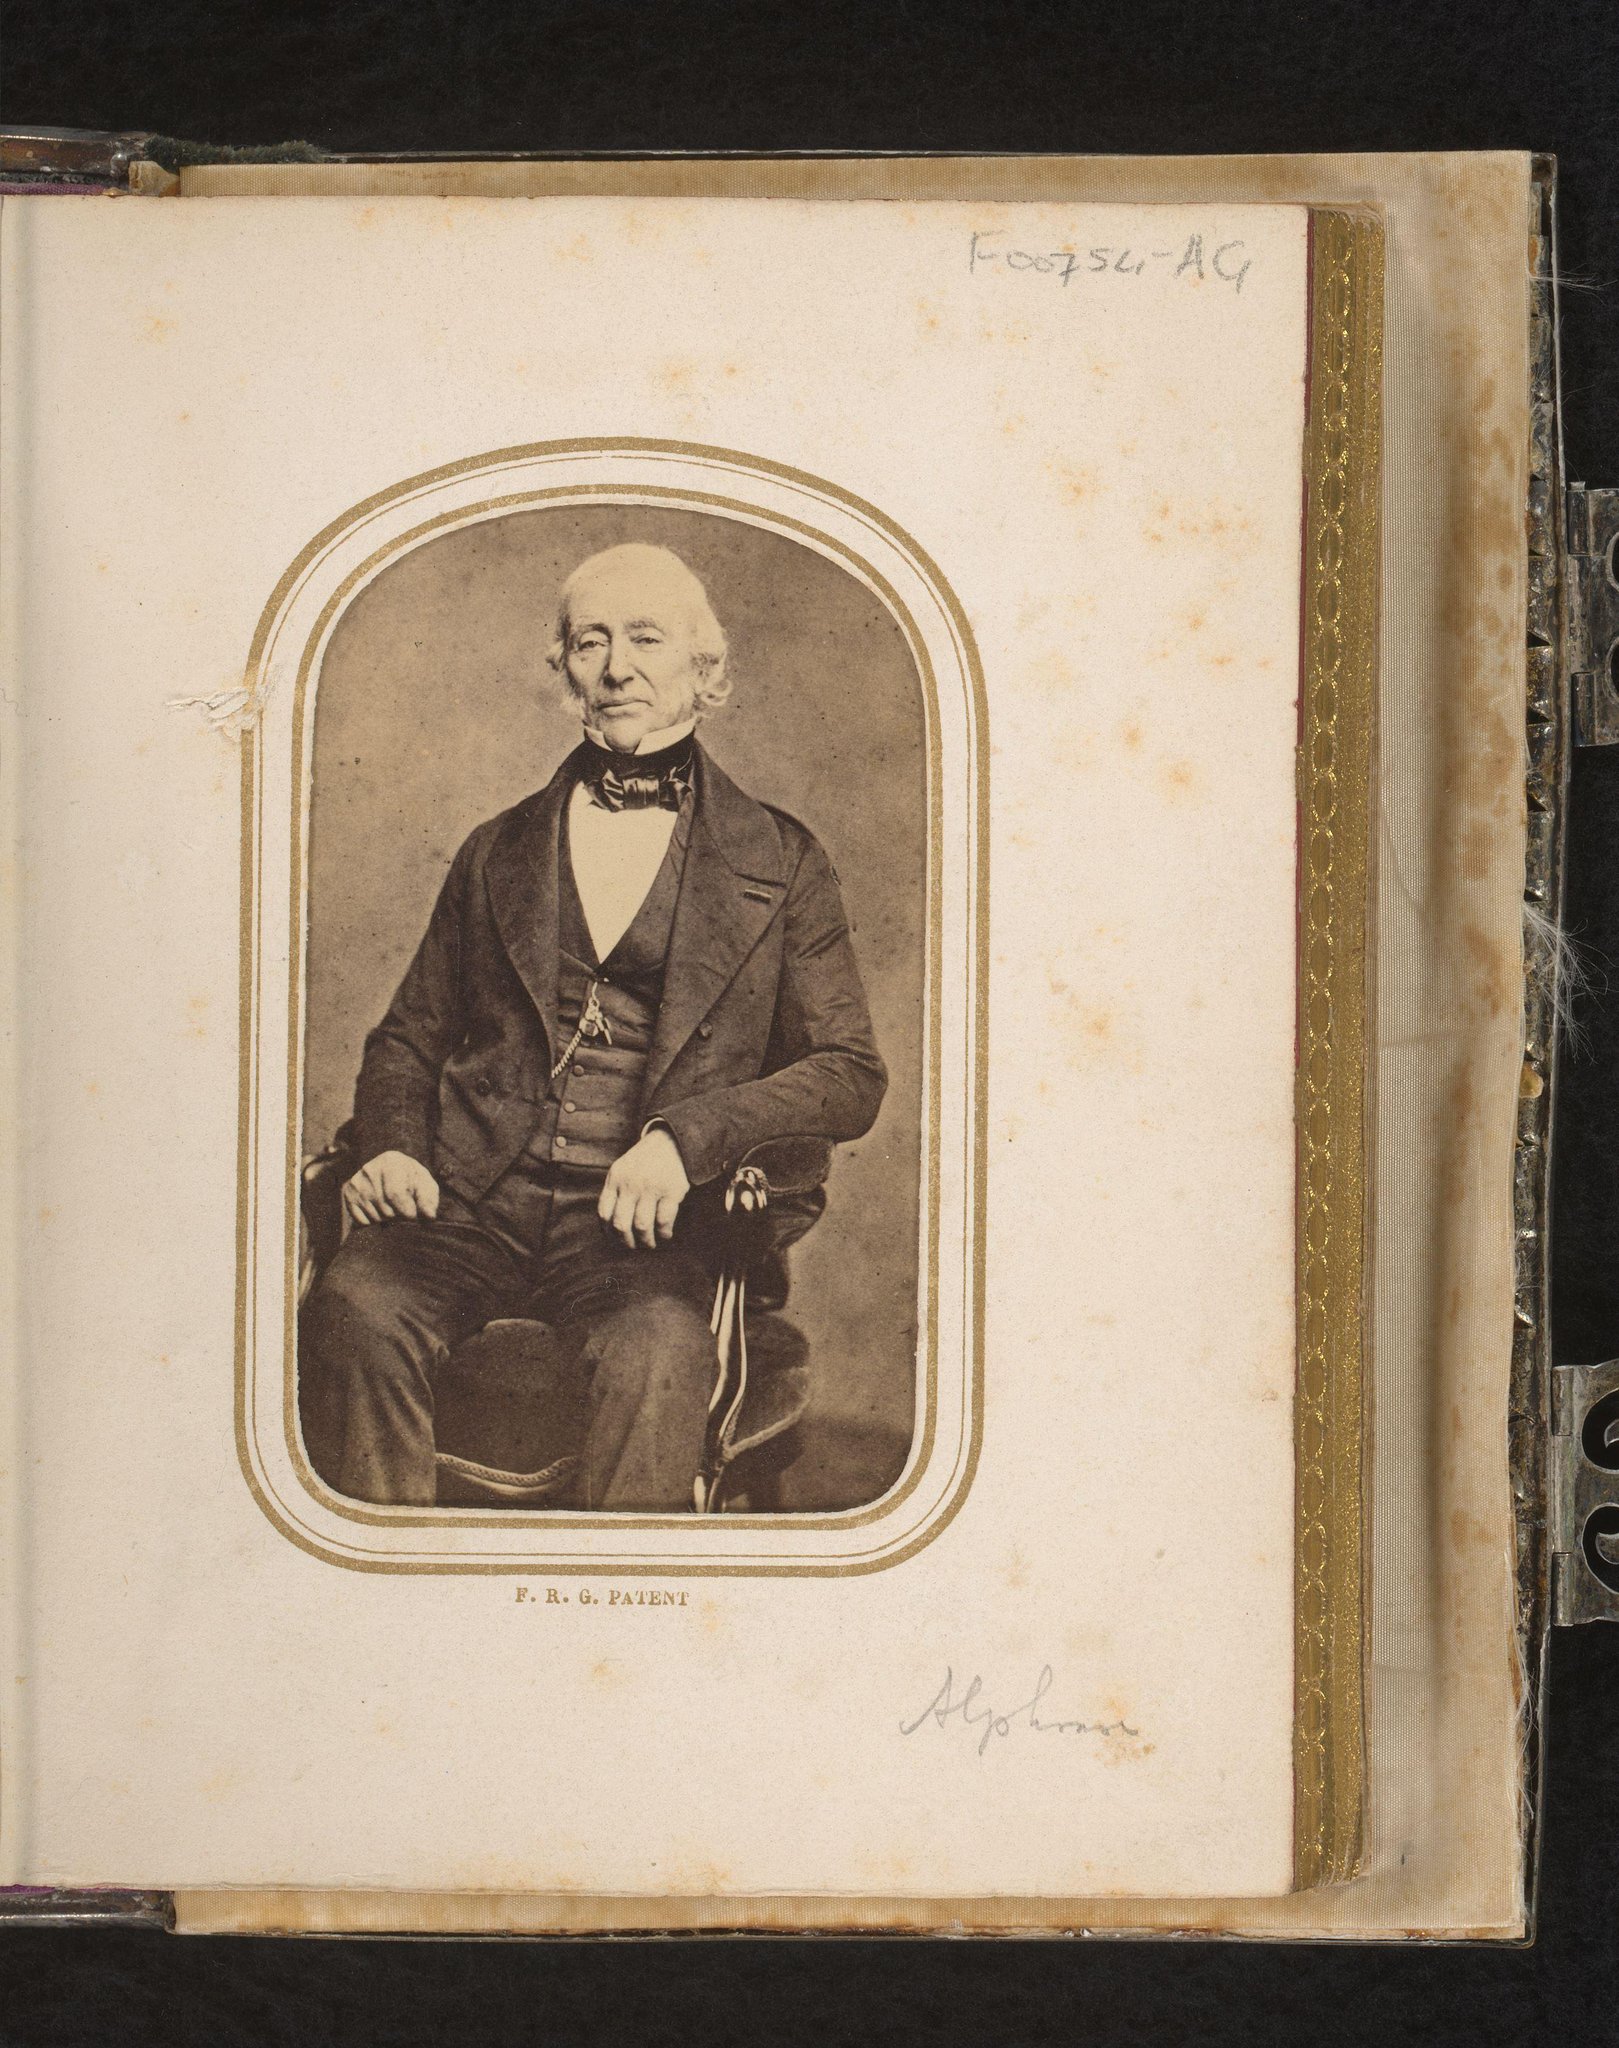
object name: album leaf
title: Portret van een man, aangeduid als grootvader Duparc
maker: alphonse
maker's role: fotograaf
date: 1855-1880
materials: cardboard, photographic support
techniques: albumen print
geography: paris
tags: old woman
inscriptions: inscription: ‘Photographie Artistique/ Alphonse/ 28, Faubourg St. Honoré, 28/ Paris’